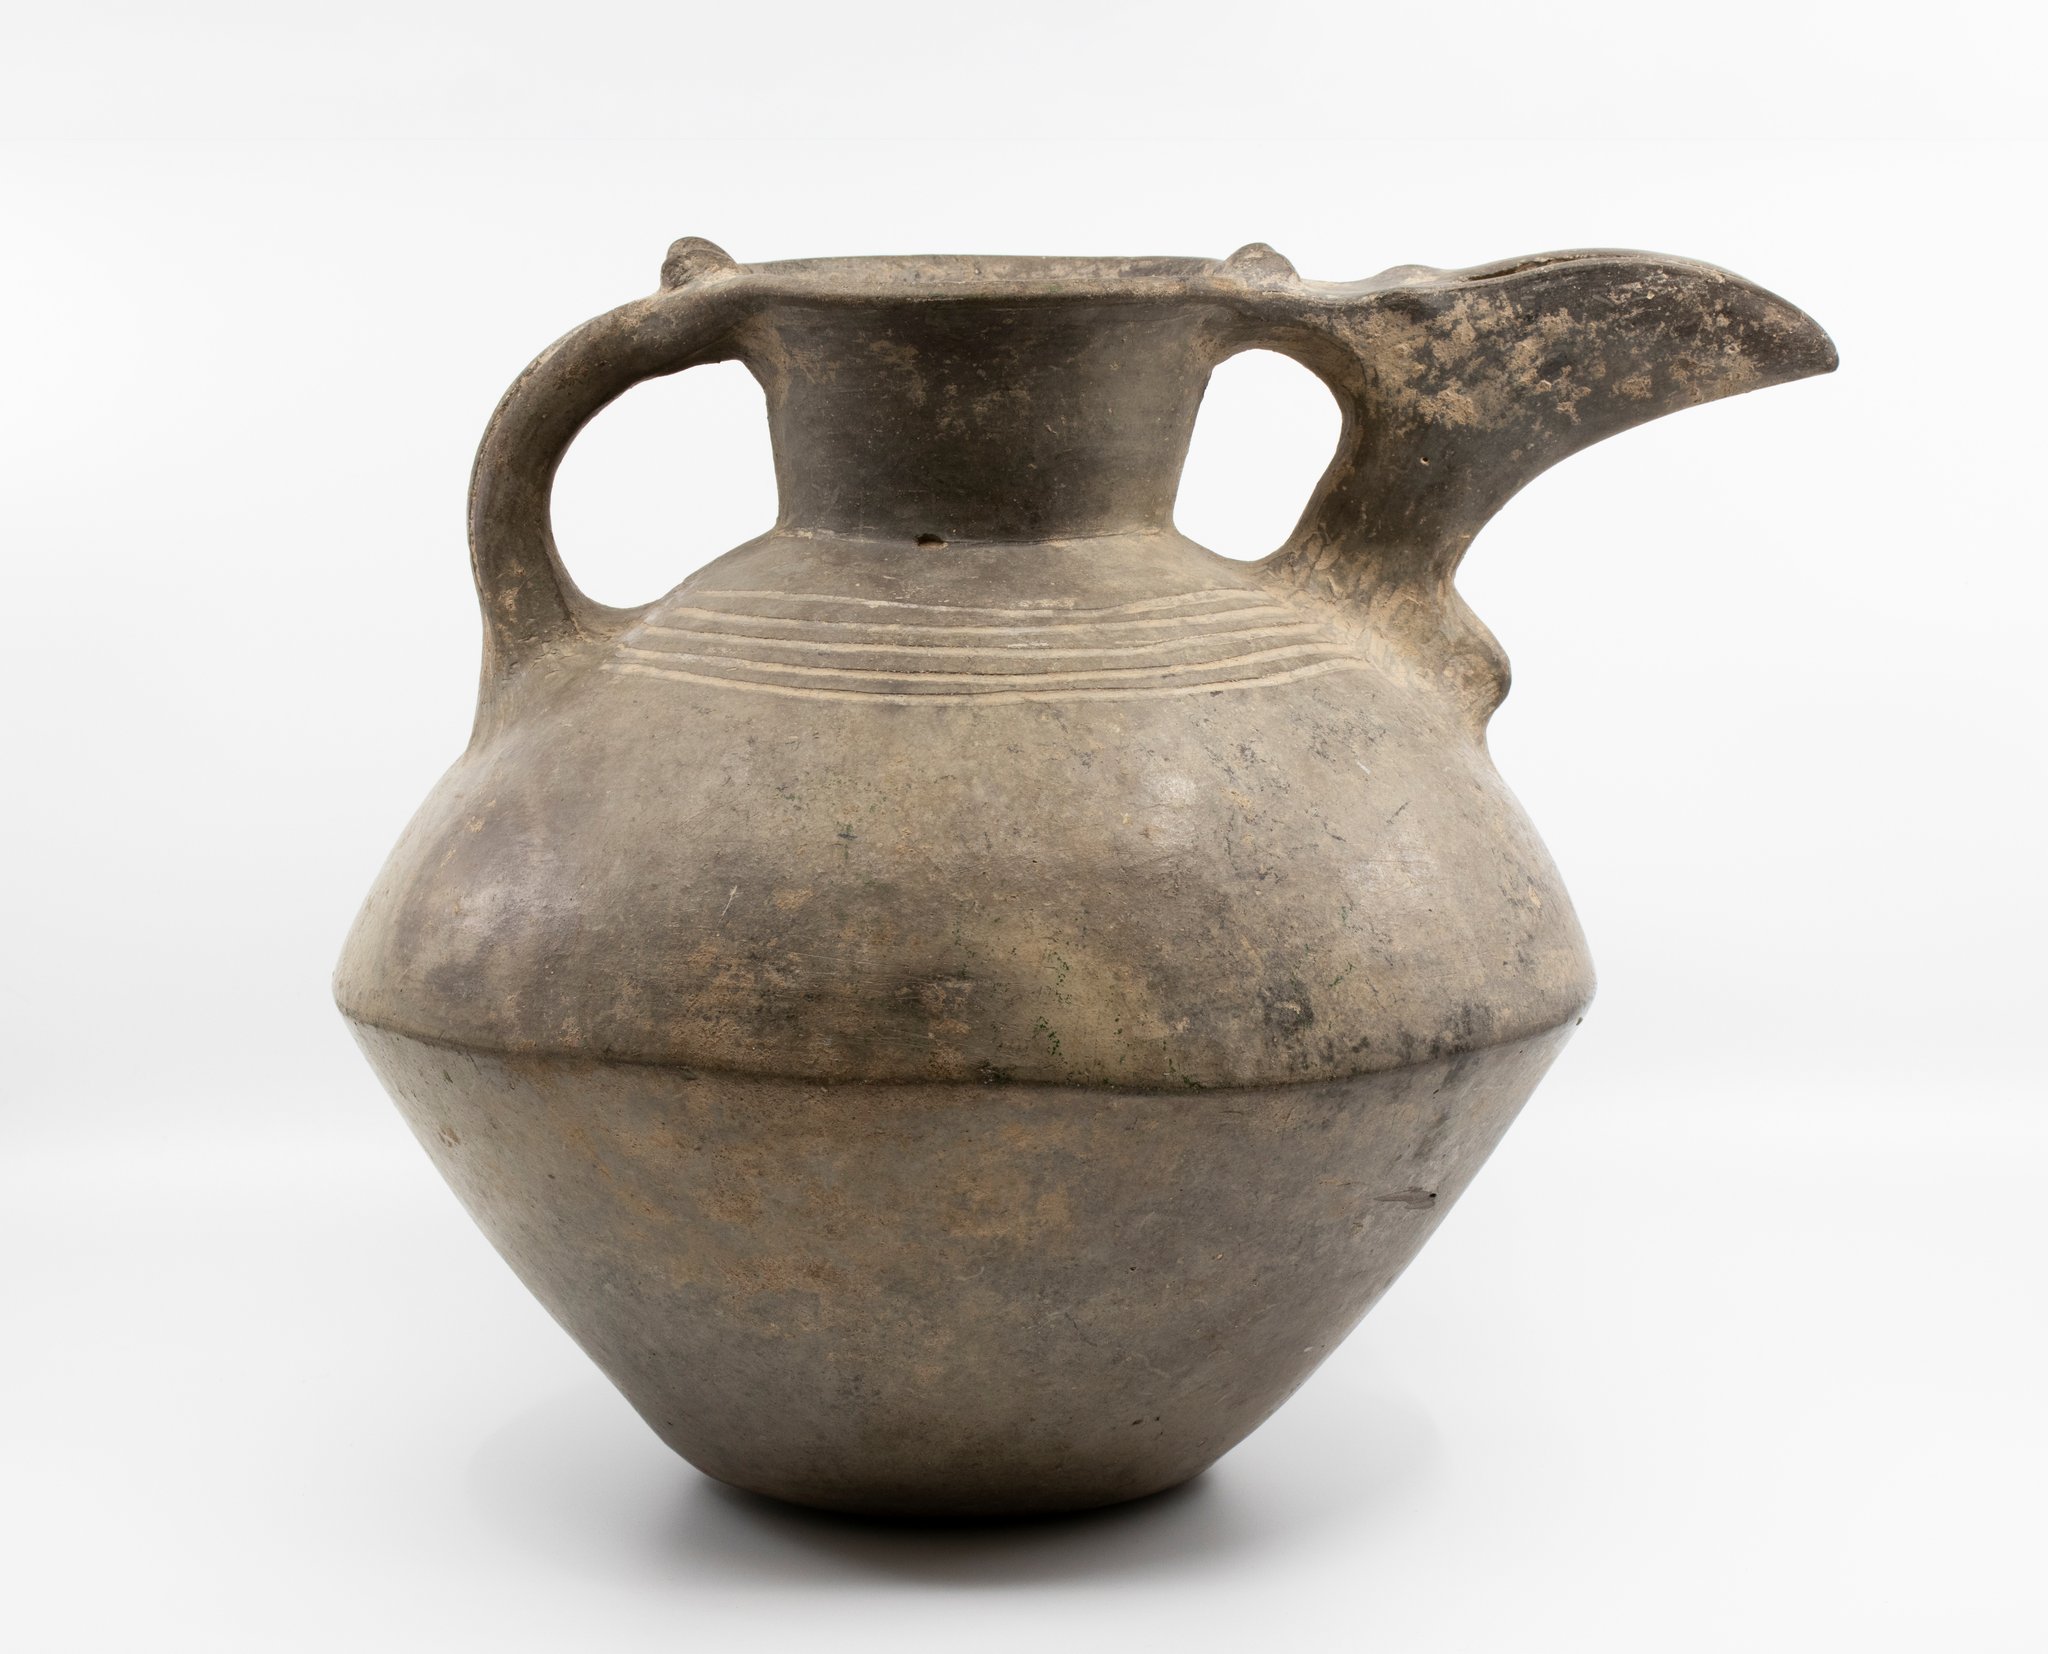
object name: jug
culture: iranian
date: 1050-800 BCE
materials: ceramic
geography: iran